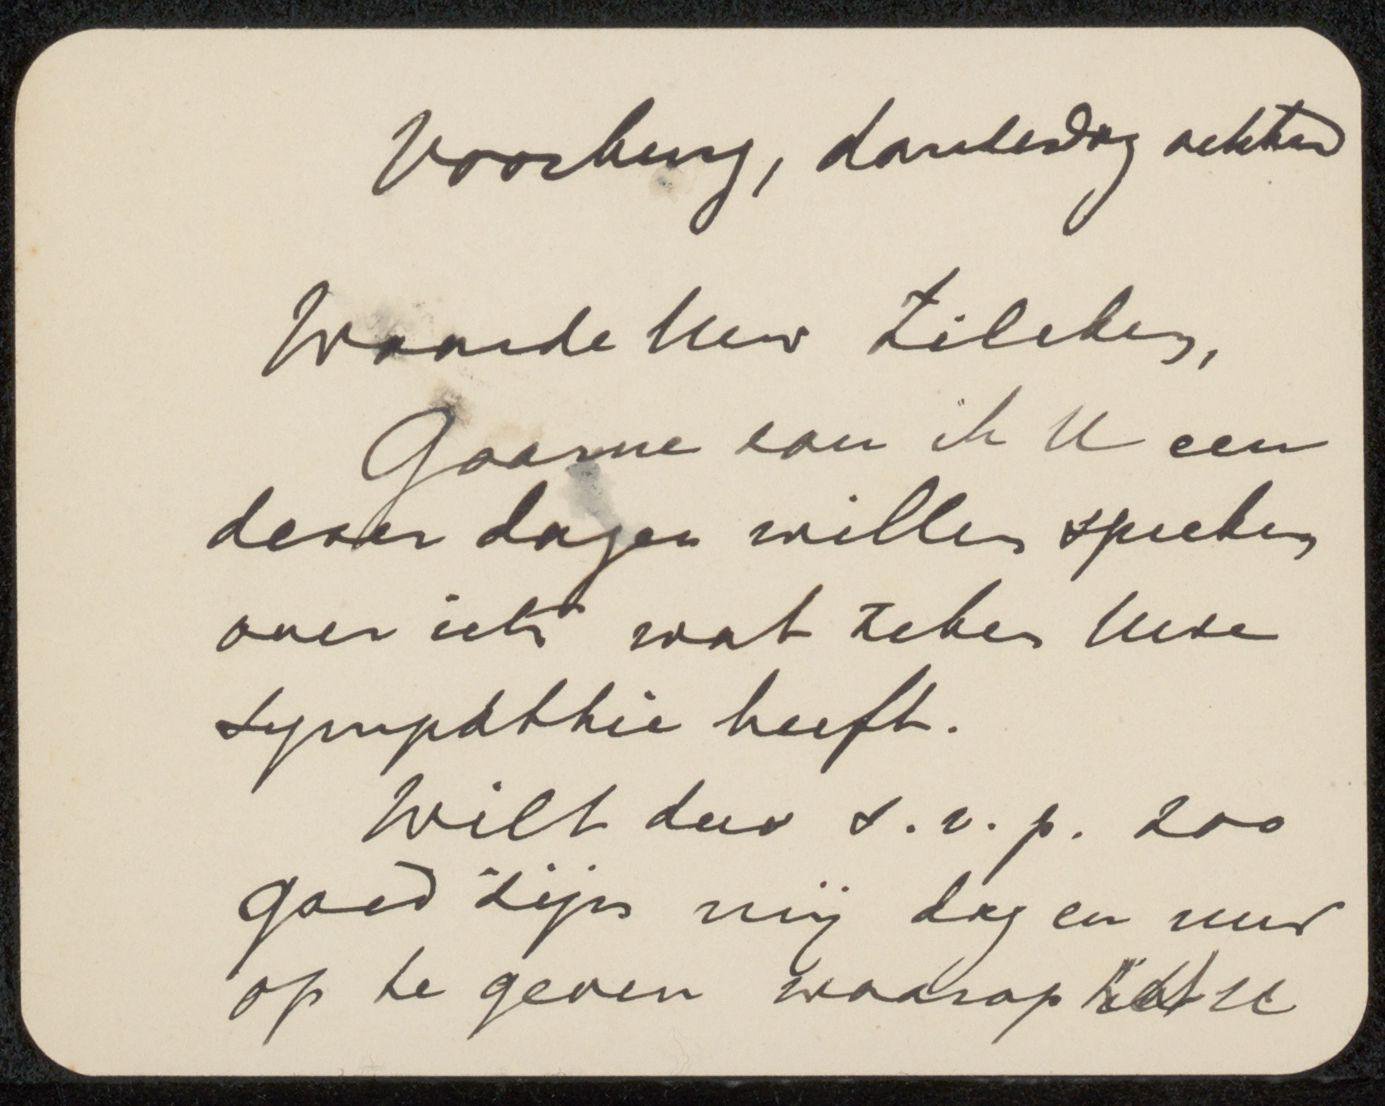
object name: letter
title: Brief aan Philip Zilcken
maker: gerke henkes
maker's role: draughtsman, painter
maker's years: 1844-1927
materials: cardboard, ink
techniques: pen, writing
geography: voorburg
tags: the hague, painter, draughtsman, philip zilcken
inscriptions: collector's mark: ‘RPK’